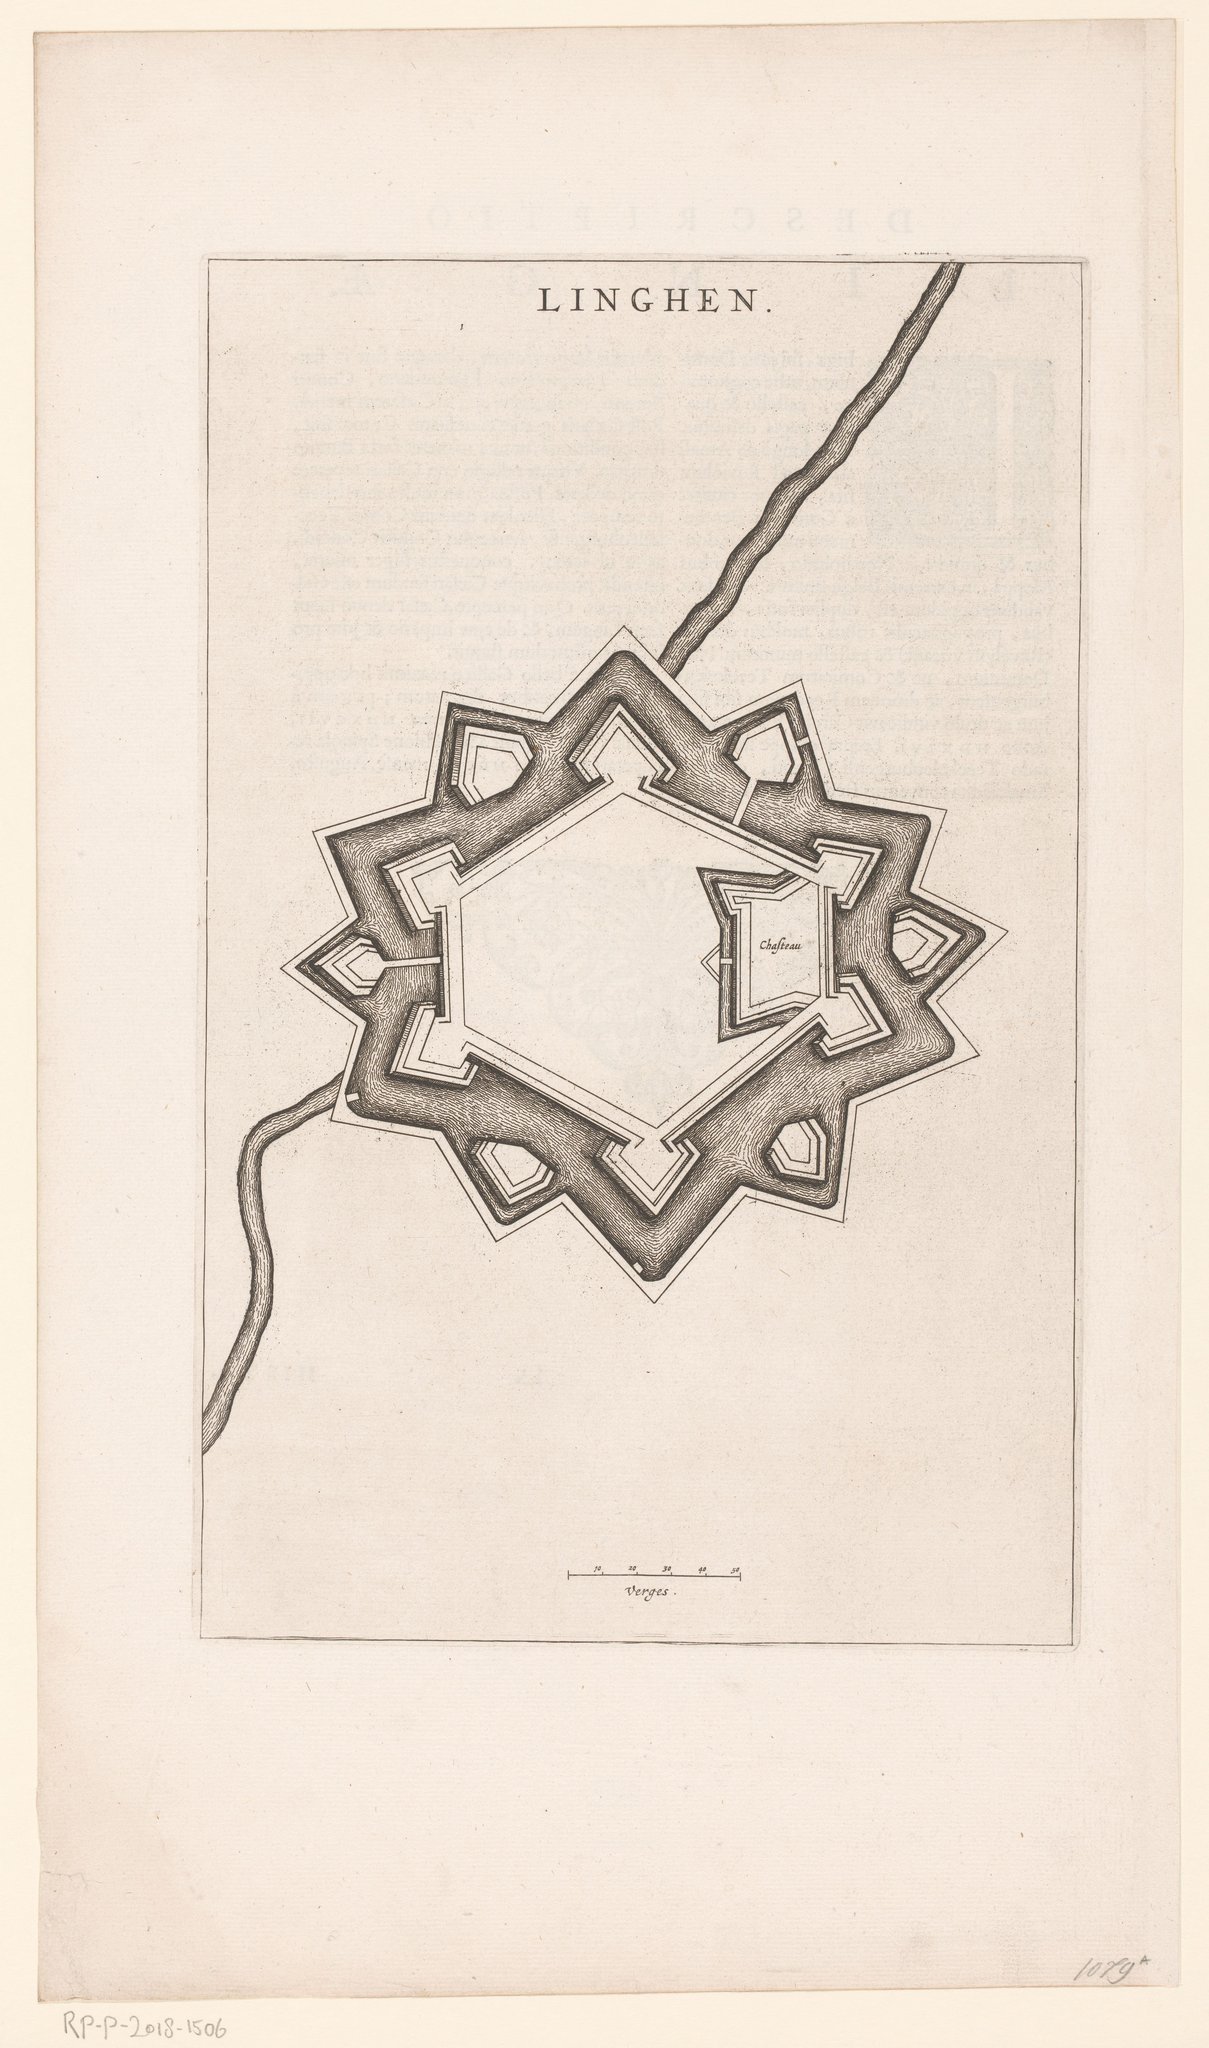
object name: area plan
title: Linghen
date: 1652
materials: paper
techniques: engraving, etching, letterpress printing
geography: amsterdam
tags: fortified city, maps of cities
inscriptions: collector's mark: Lugt 2228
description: Prent gebruikt in: Blaeu, Johannes Willemszoon. Novum ac magnum theatrum urbium Belgicae (...). 2 dln. 3e druk. Amsterdam: Johannes Willemszoon Blaeu, 1652, dl. 1.